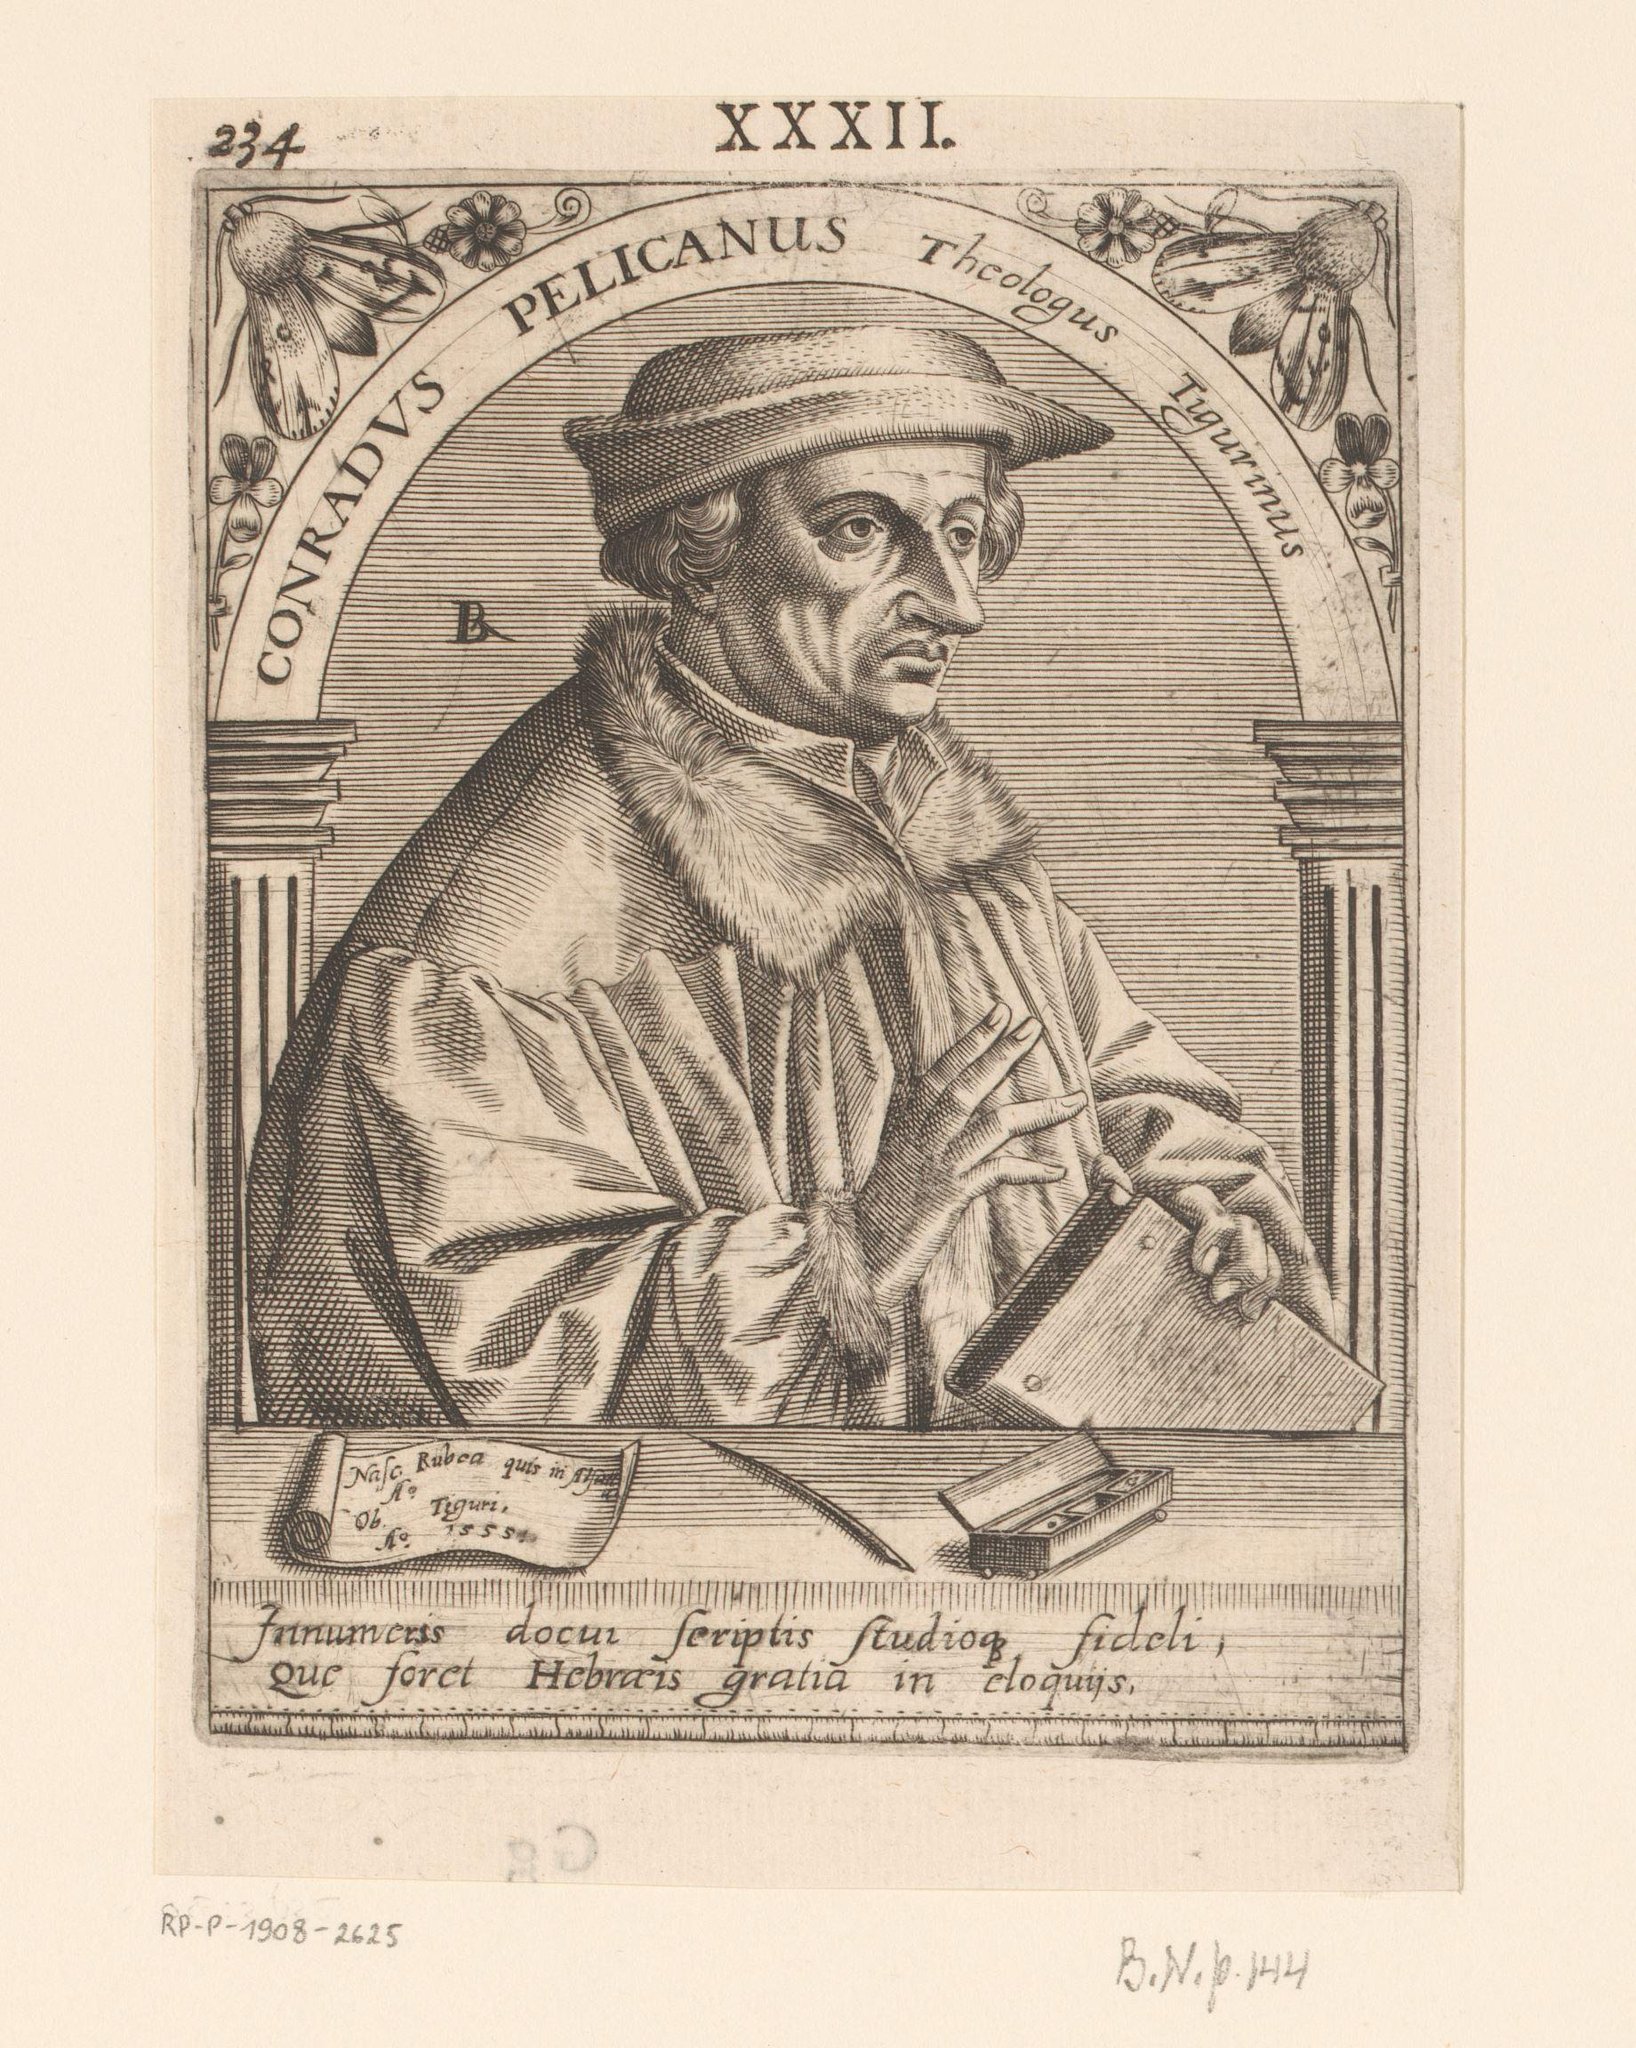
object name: print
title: Serie portretten van vijftiende- en zestiende-eeuwse geleerden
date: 1597-1599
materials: paper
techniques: engraving, letterpress printing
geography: france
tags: ink-well, historical persons, insects: moth, book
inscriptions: collector's mark: Lugt 2228